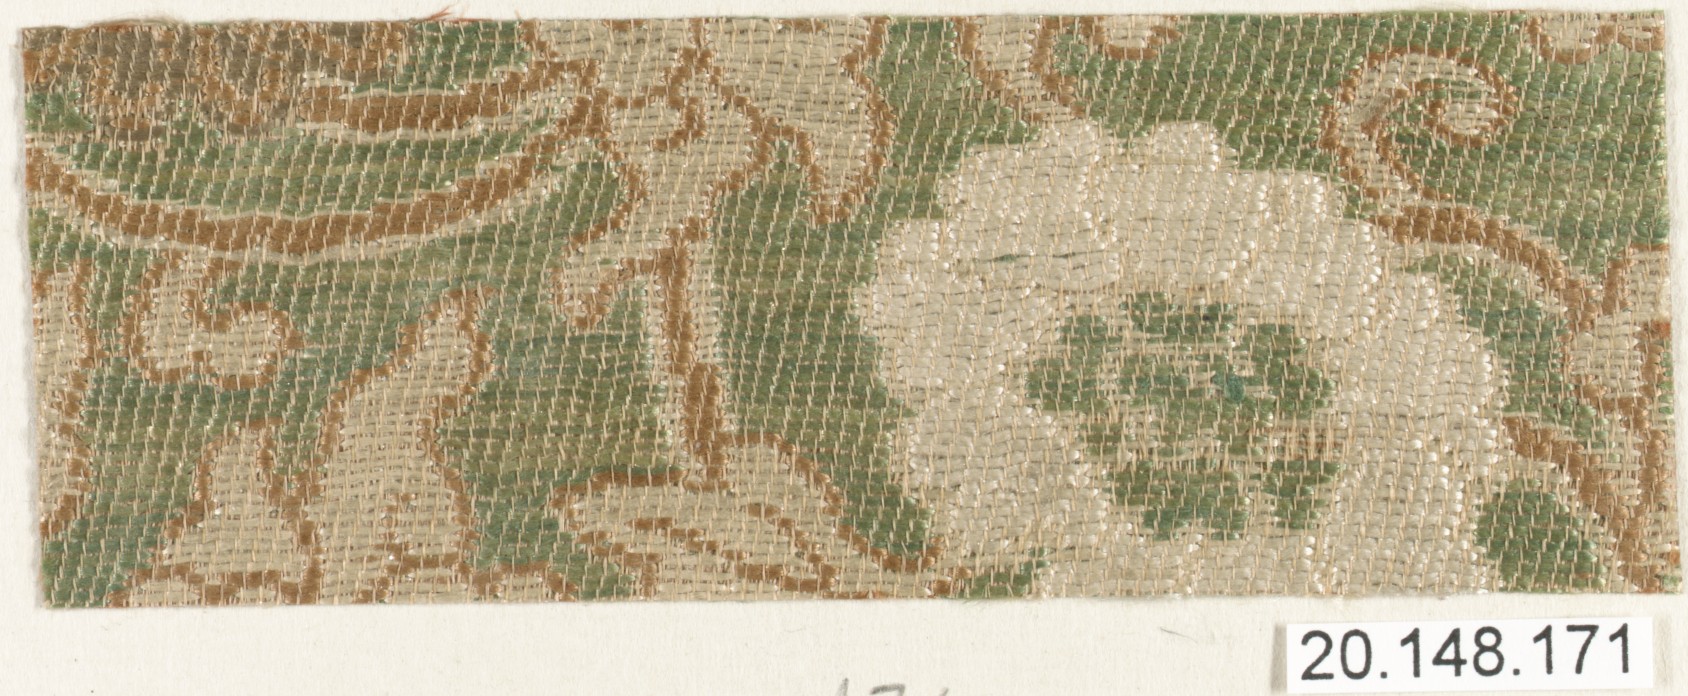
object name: piece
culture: japanese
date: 1701-1800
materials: silk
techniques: compound weave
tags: flowers